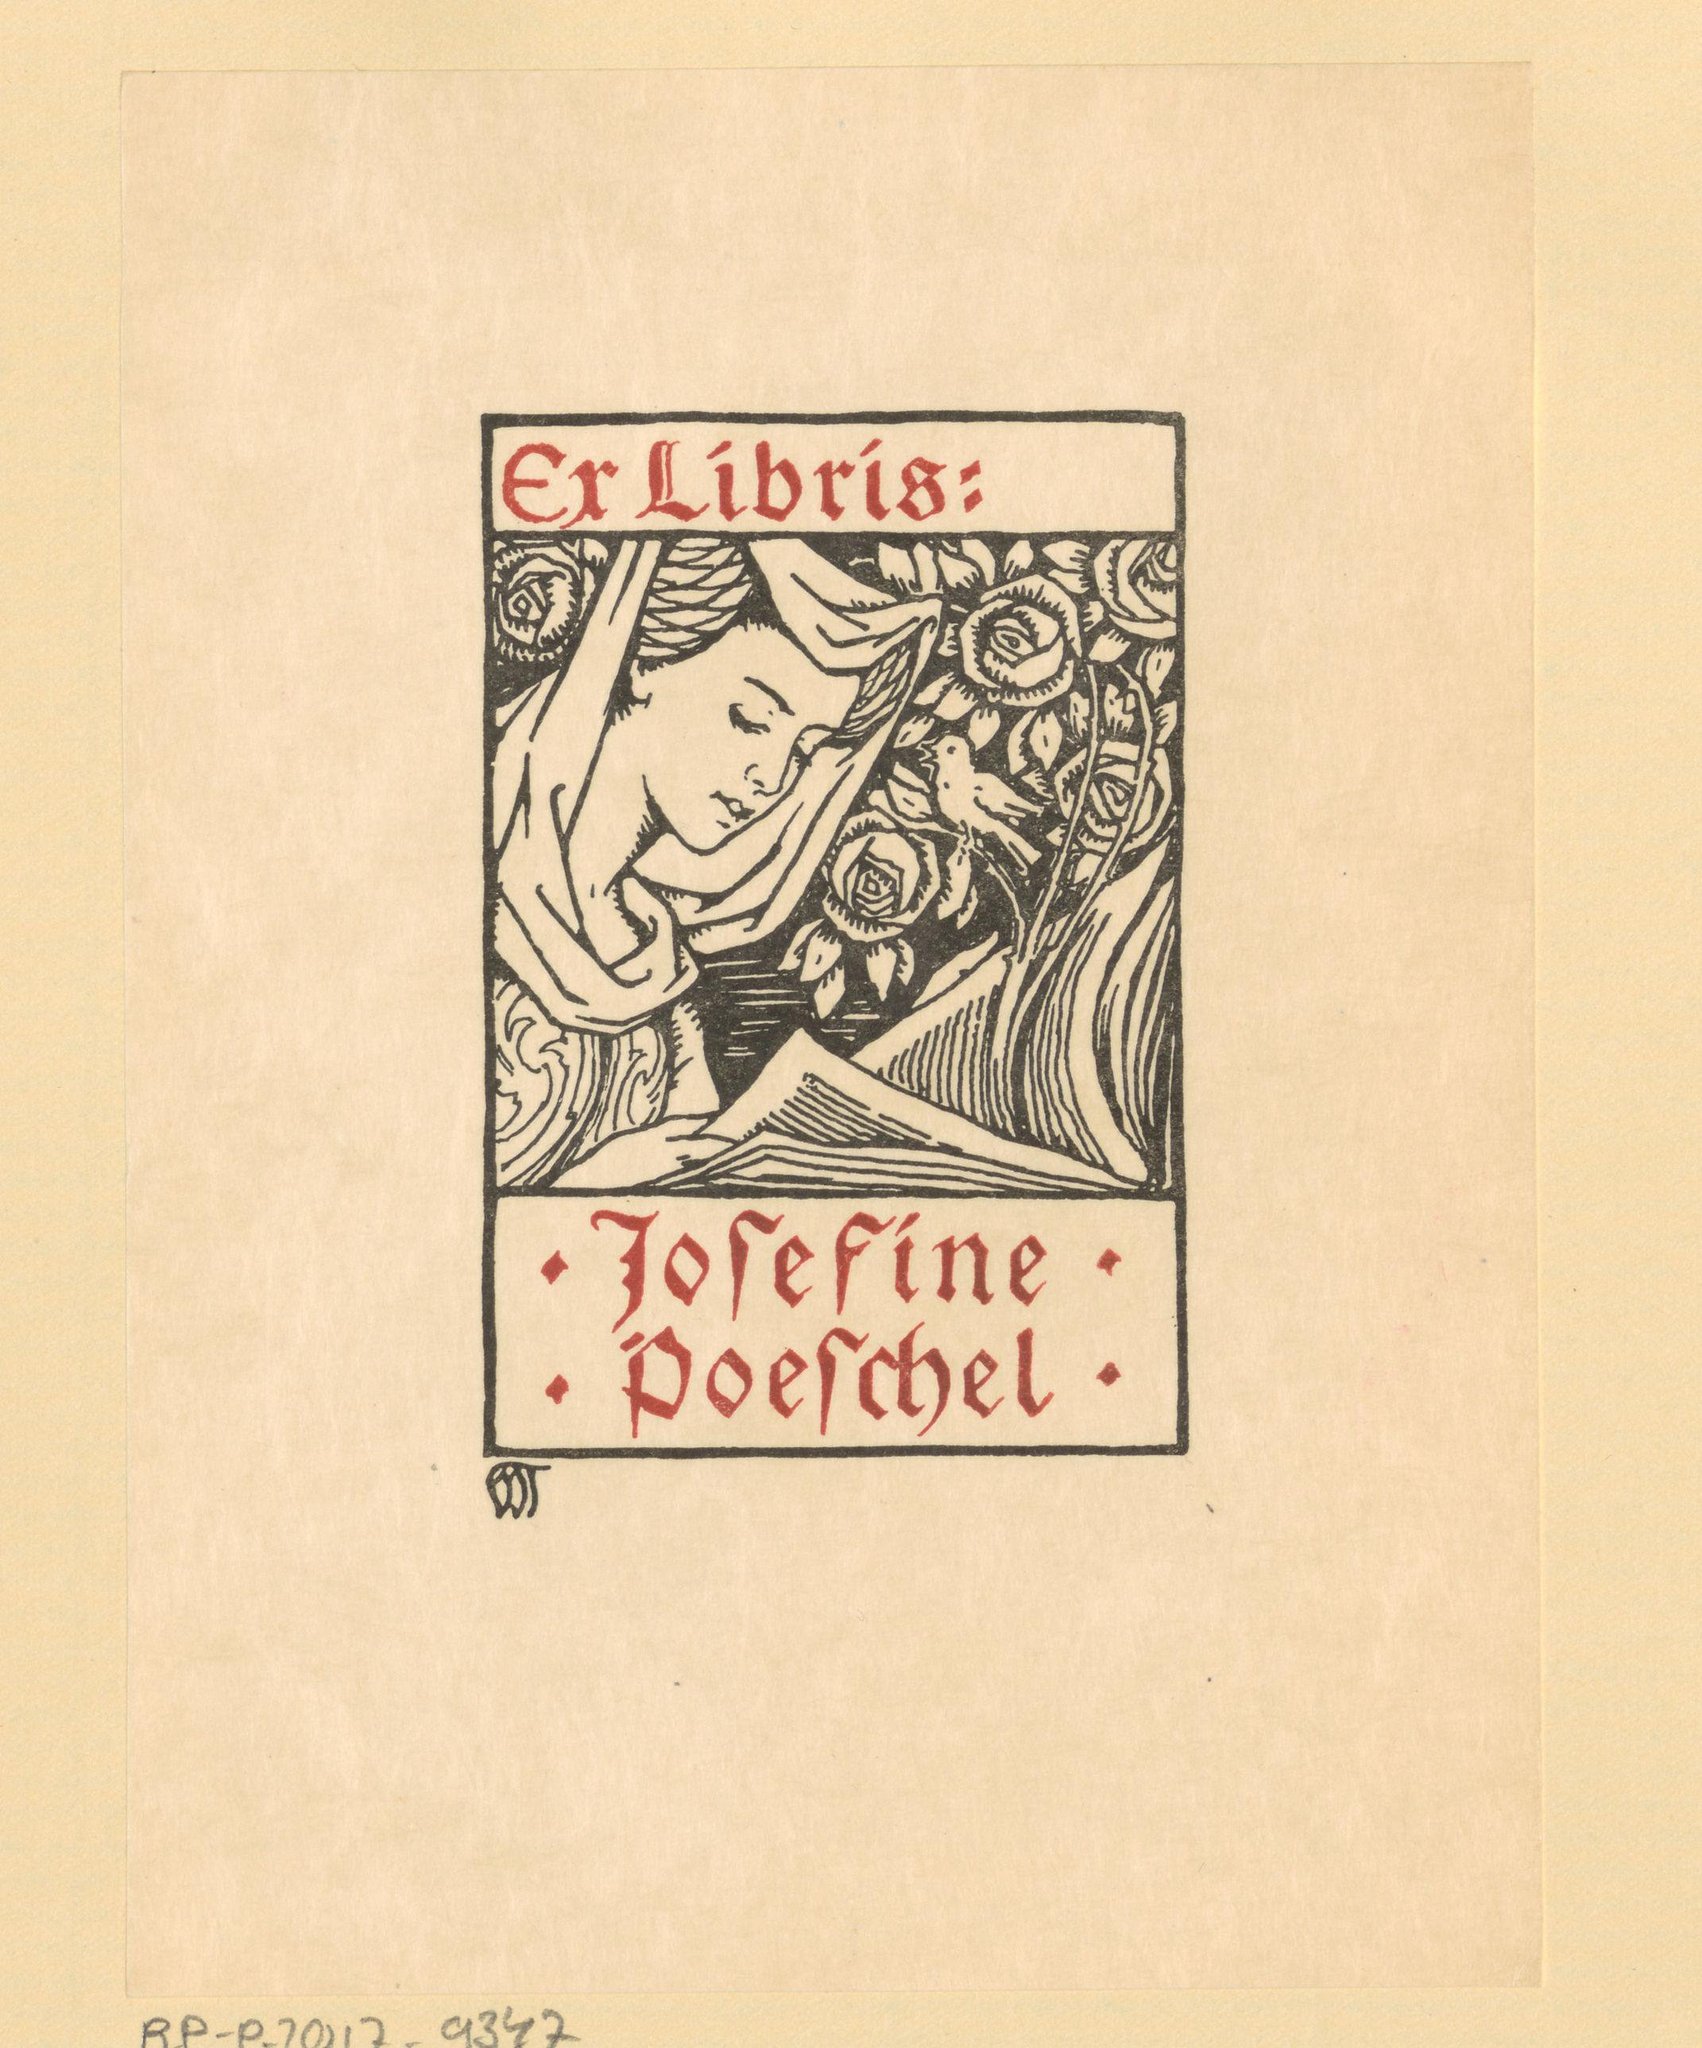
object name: bookplate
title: Ex libris: Josefine Poeschel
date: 1886-1951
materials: paper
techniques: printing block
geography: germany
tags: reading, historical costume, flowers: rose, head (human) - aa - female human figure